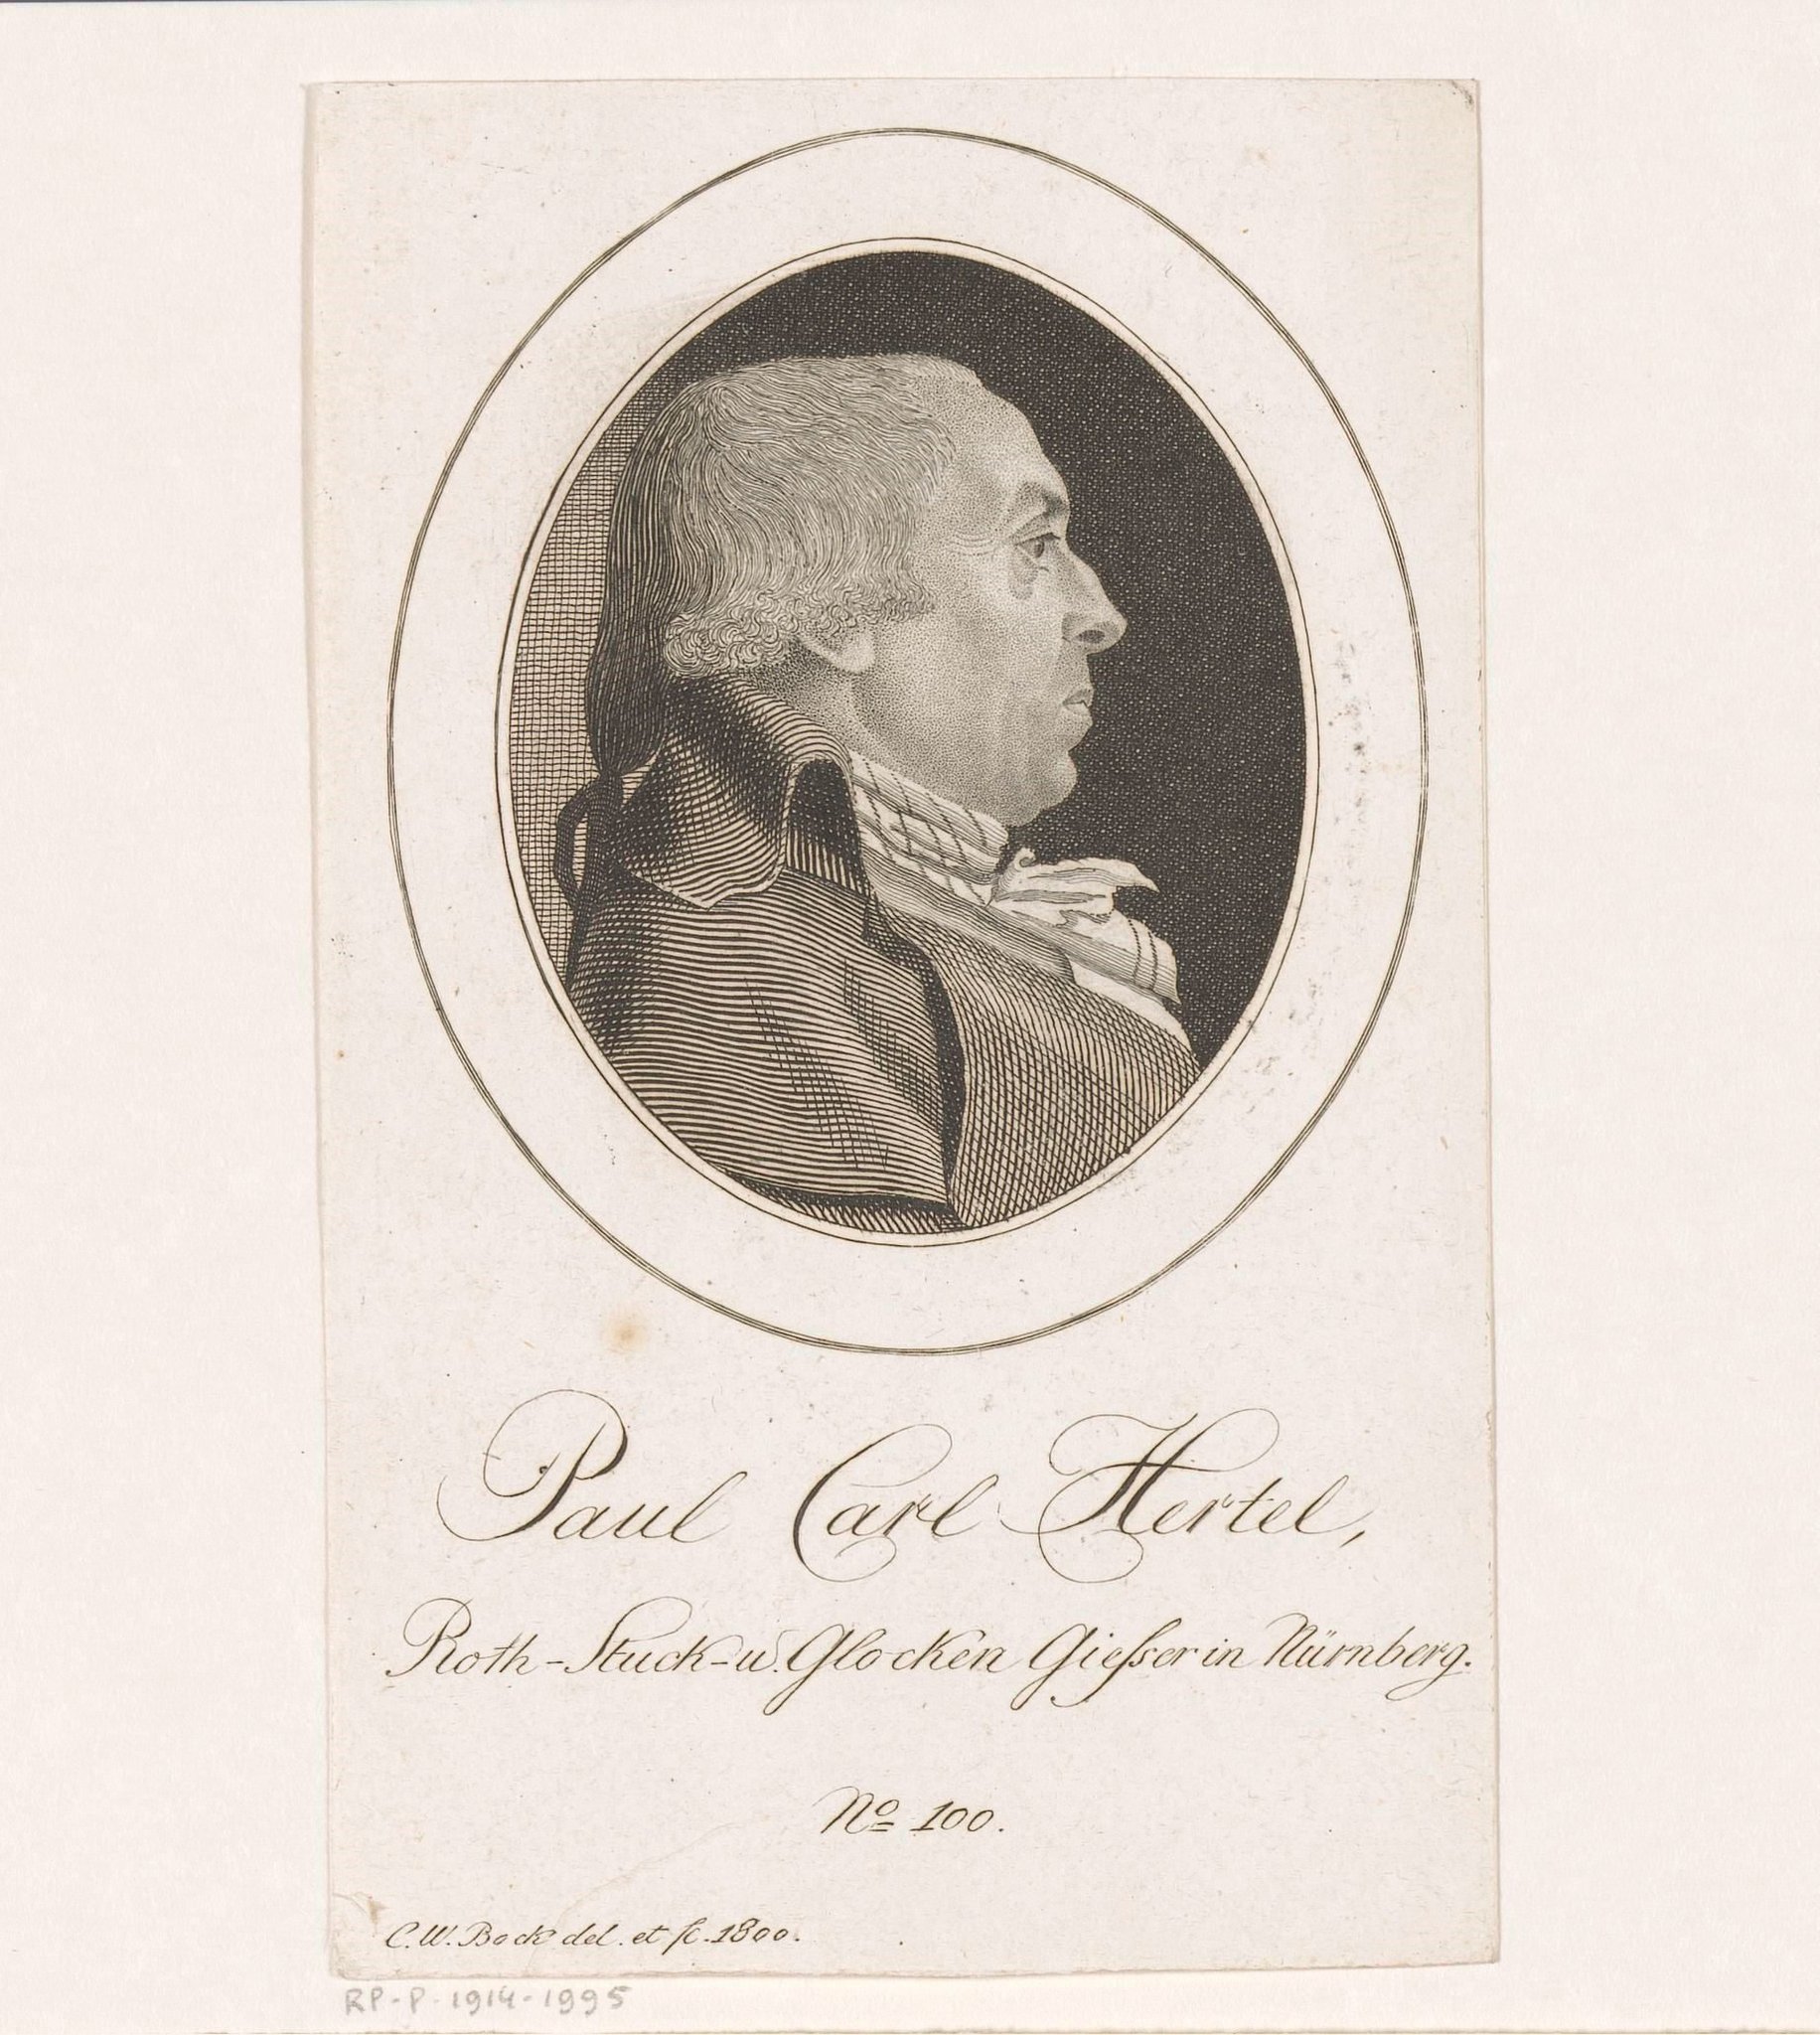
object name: print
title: Portret van Paul Carl Hertel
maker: christoph wilhelm bock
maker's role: print maker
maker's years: 1755-1836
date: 1800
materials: paper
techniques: engraving, etching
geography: nuremberg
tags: historical persons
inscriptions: collector's mark: Lugt 2228